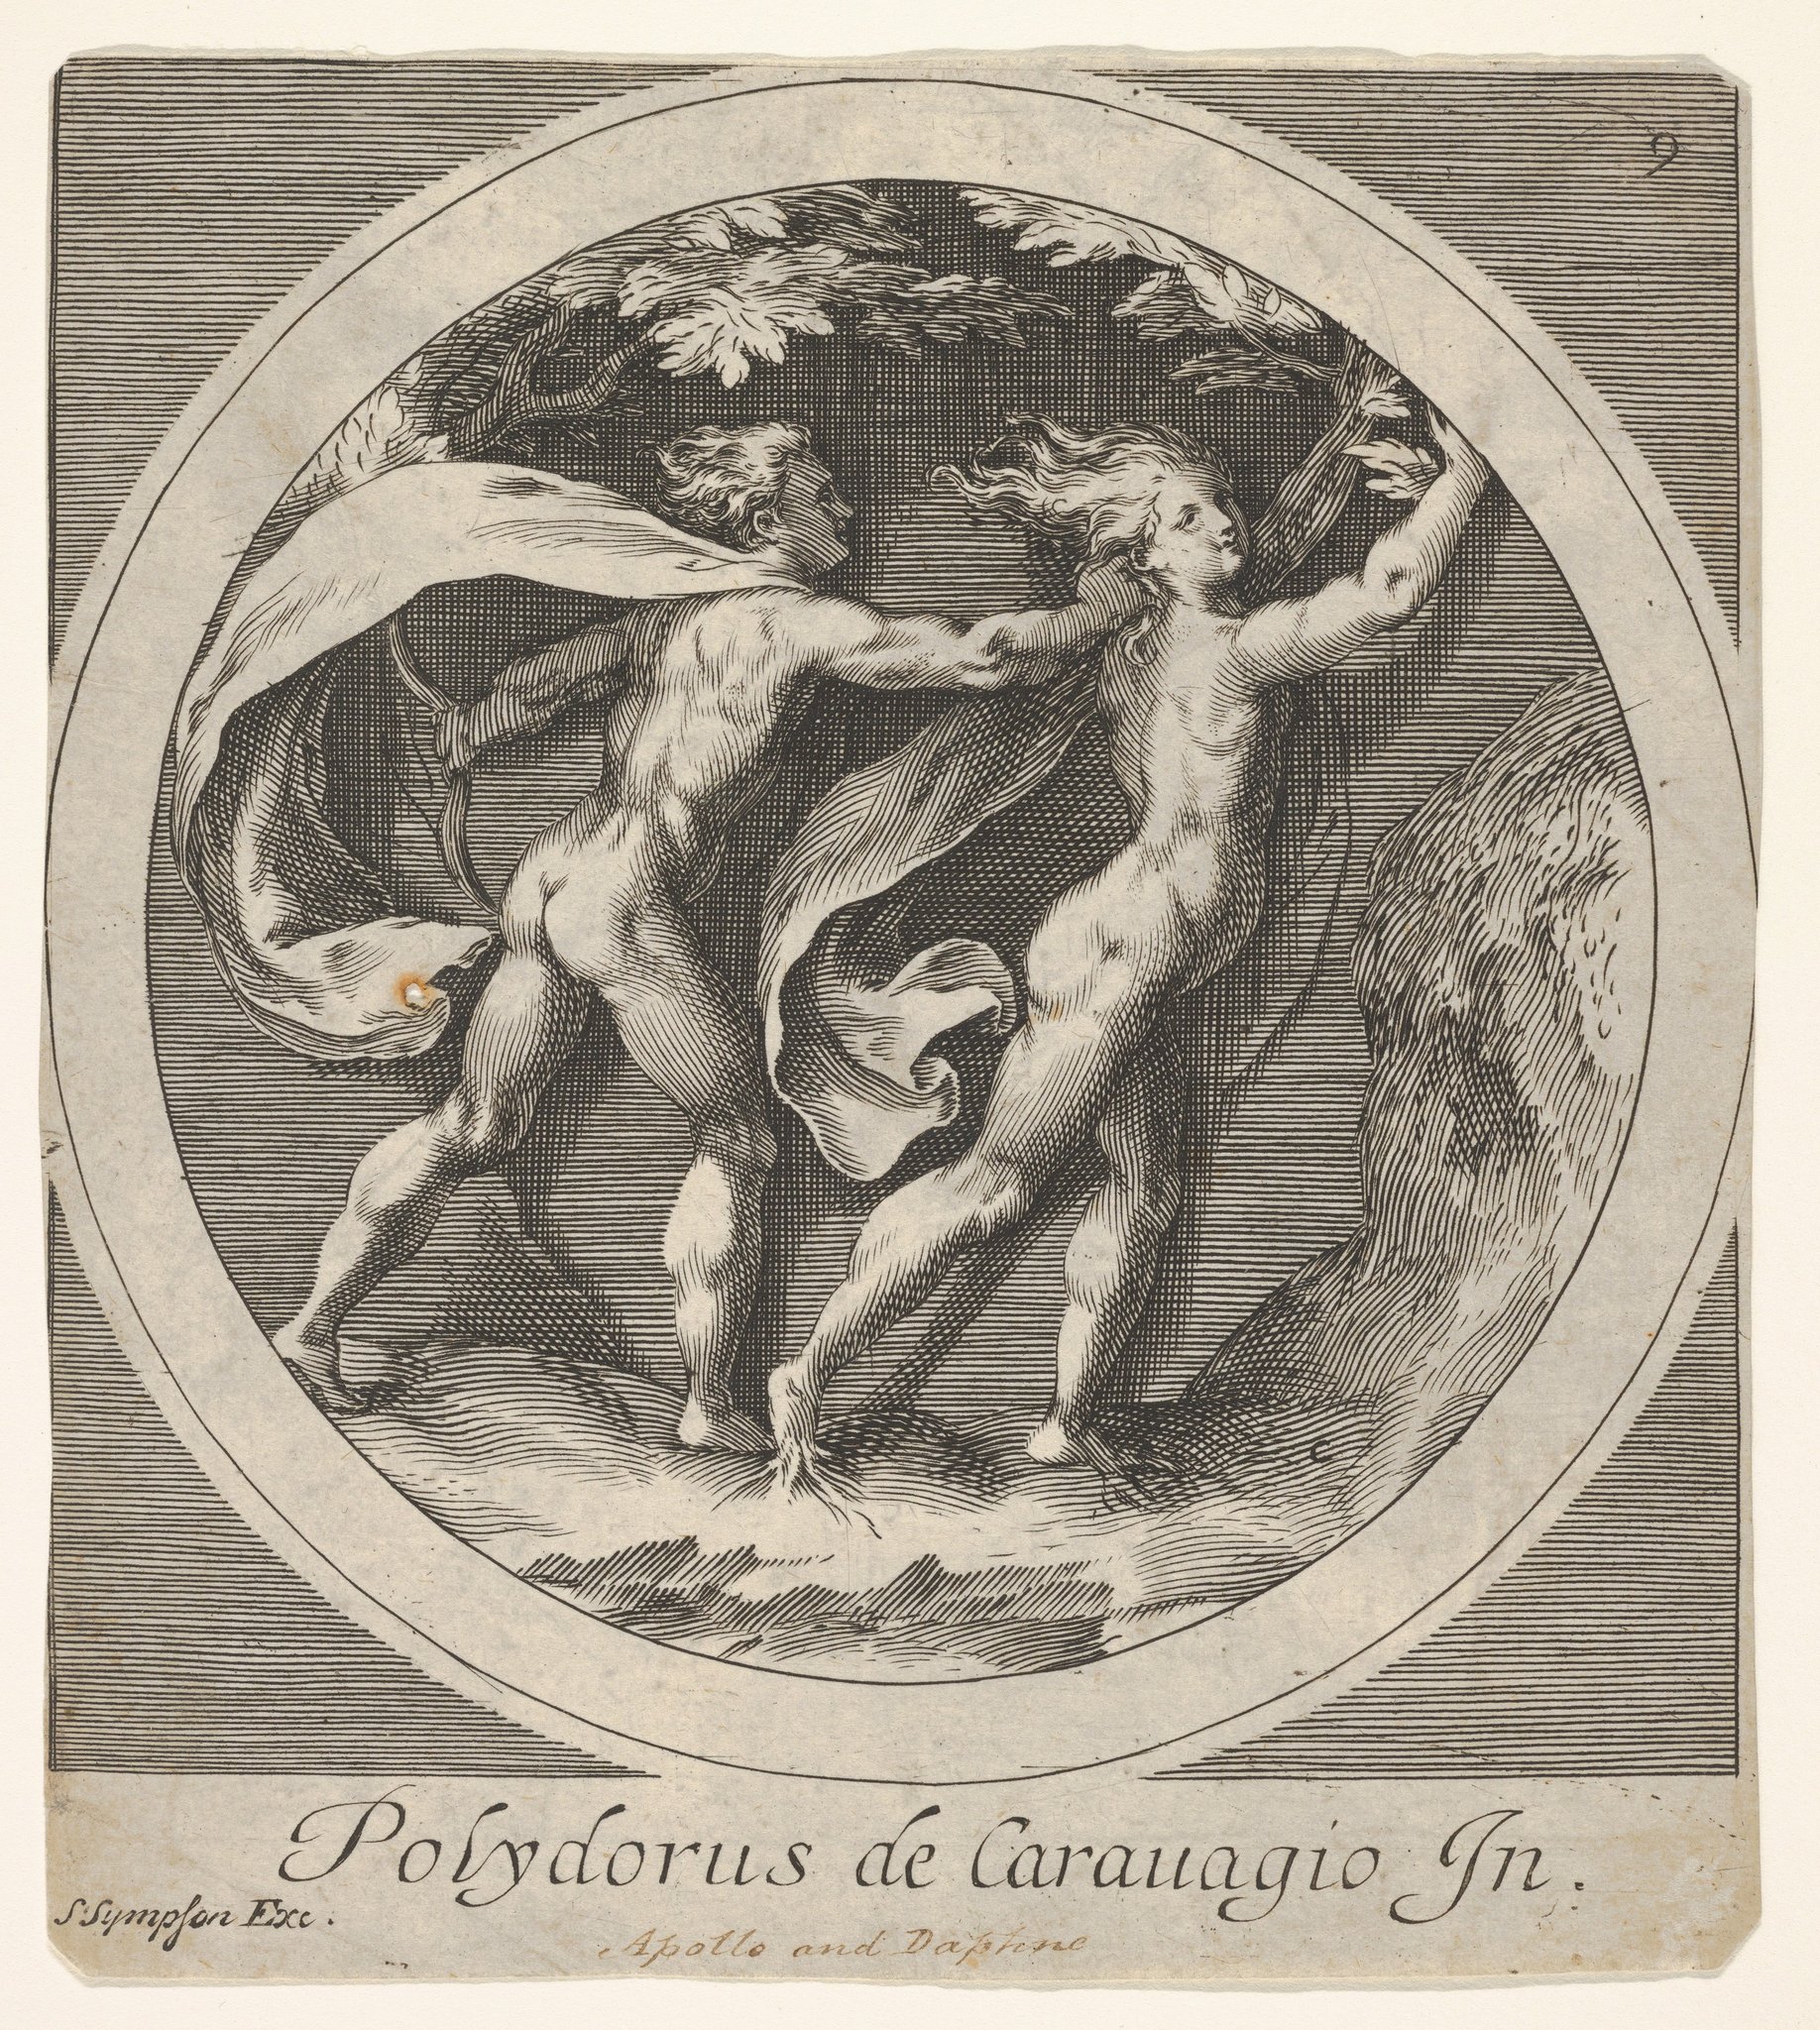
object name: print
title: Apollo pursuing Daphne, whose toes take the form of tree roots, a round composition, reverse copy after a series of engravings by Cherubino Alberti of mythological scenes after Polidoro da Caravaggio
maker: Anonymous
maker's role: artist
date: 1550-1600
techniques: engraving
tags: apollo,trees